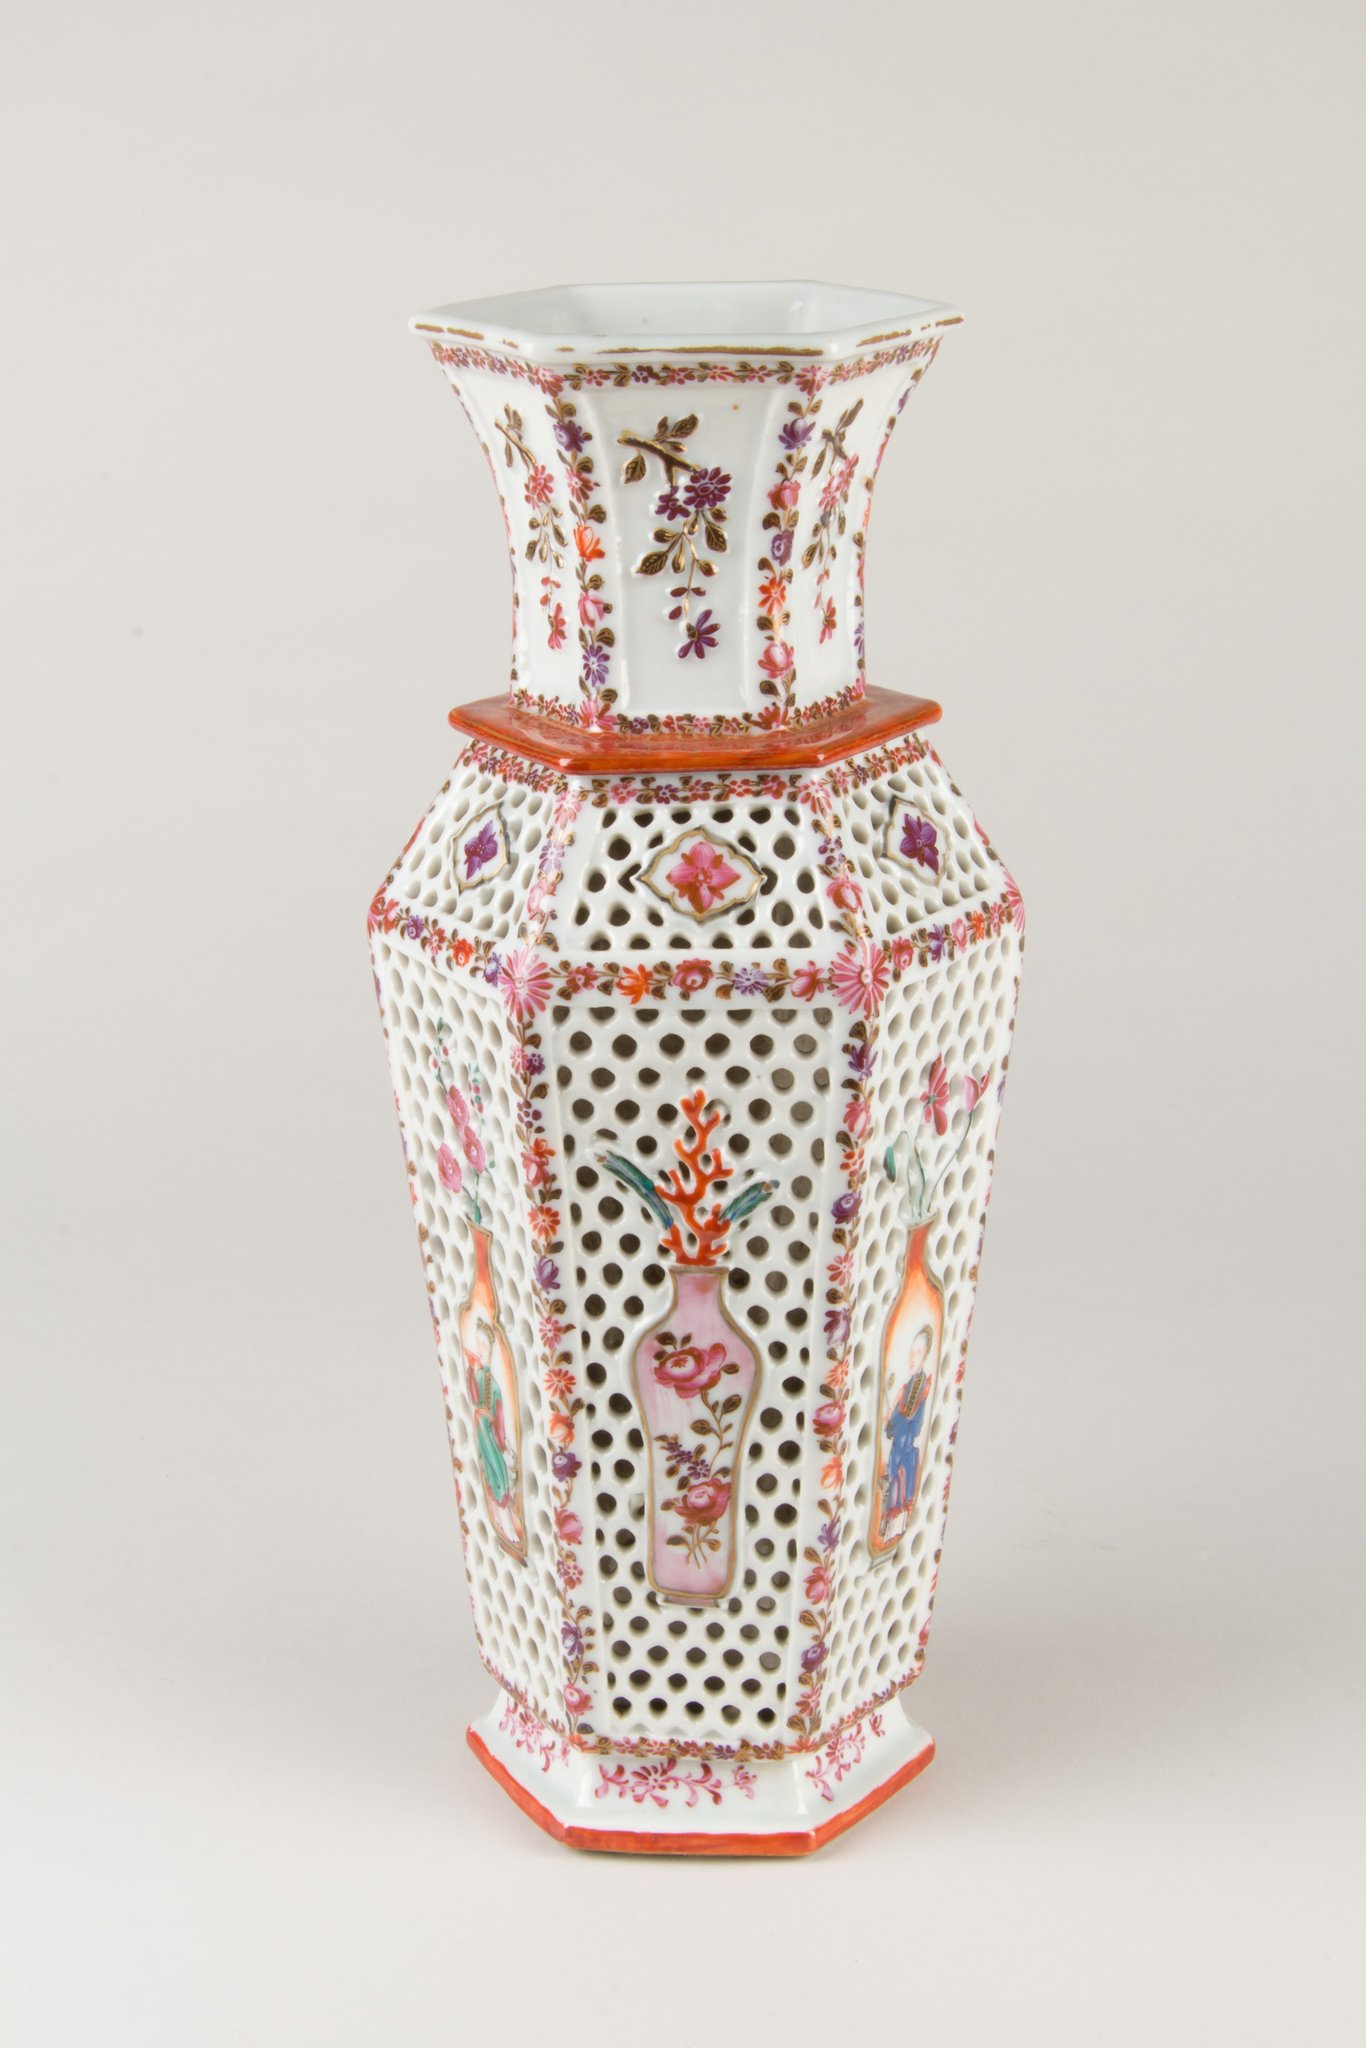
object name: vase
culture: chinese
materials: enamel, porcelain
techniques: overglaze, painting, polychrome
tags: flowers